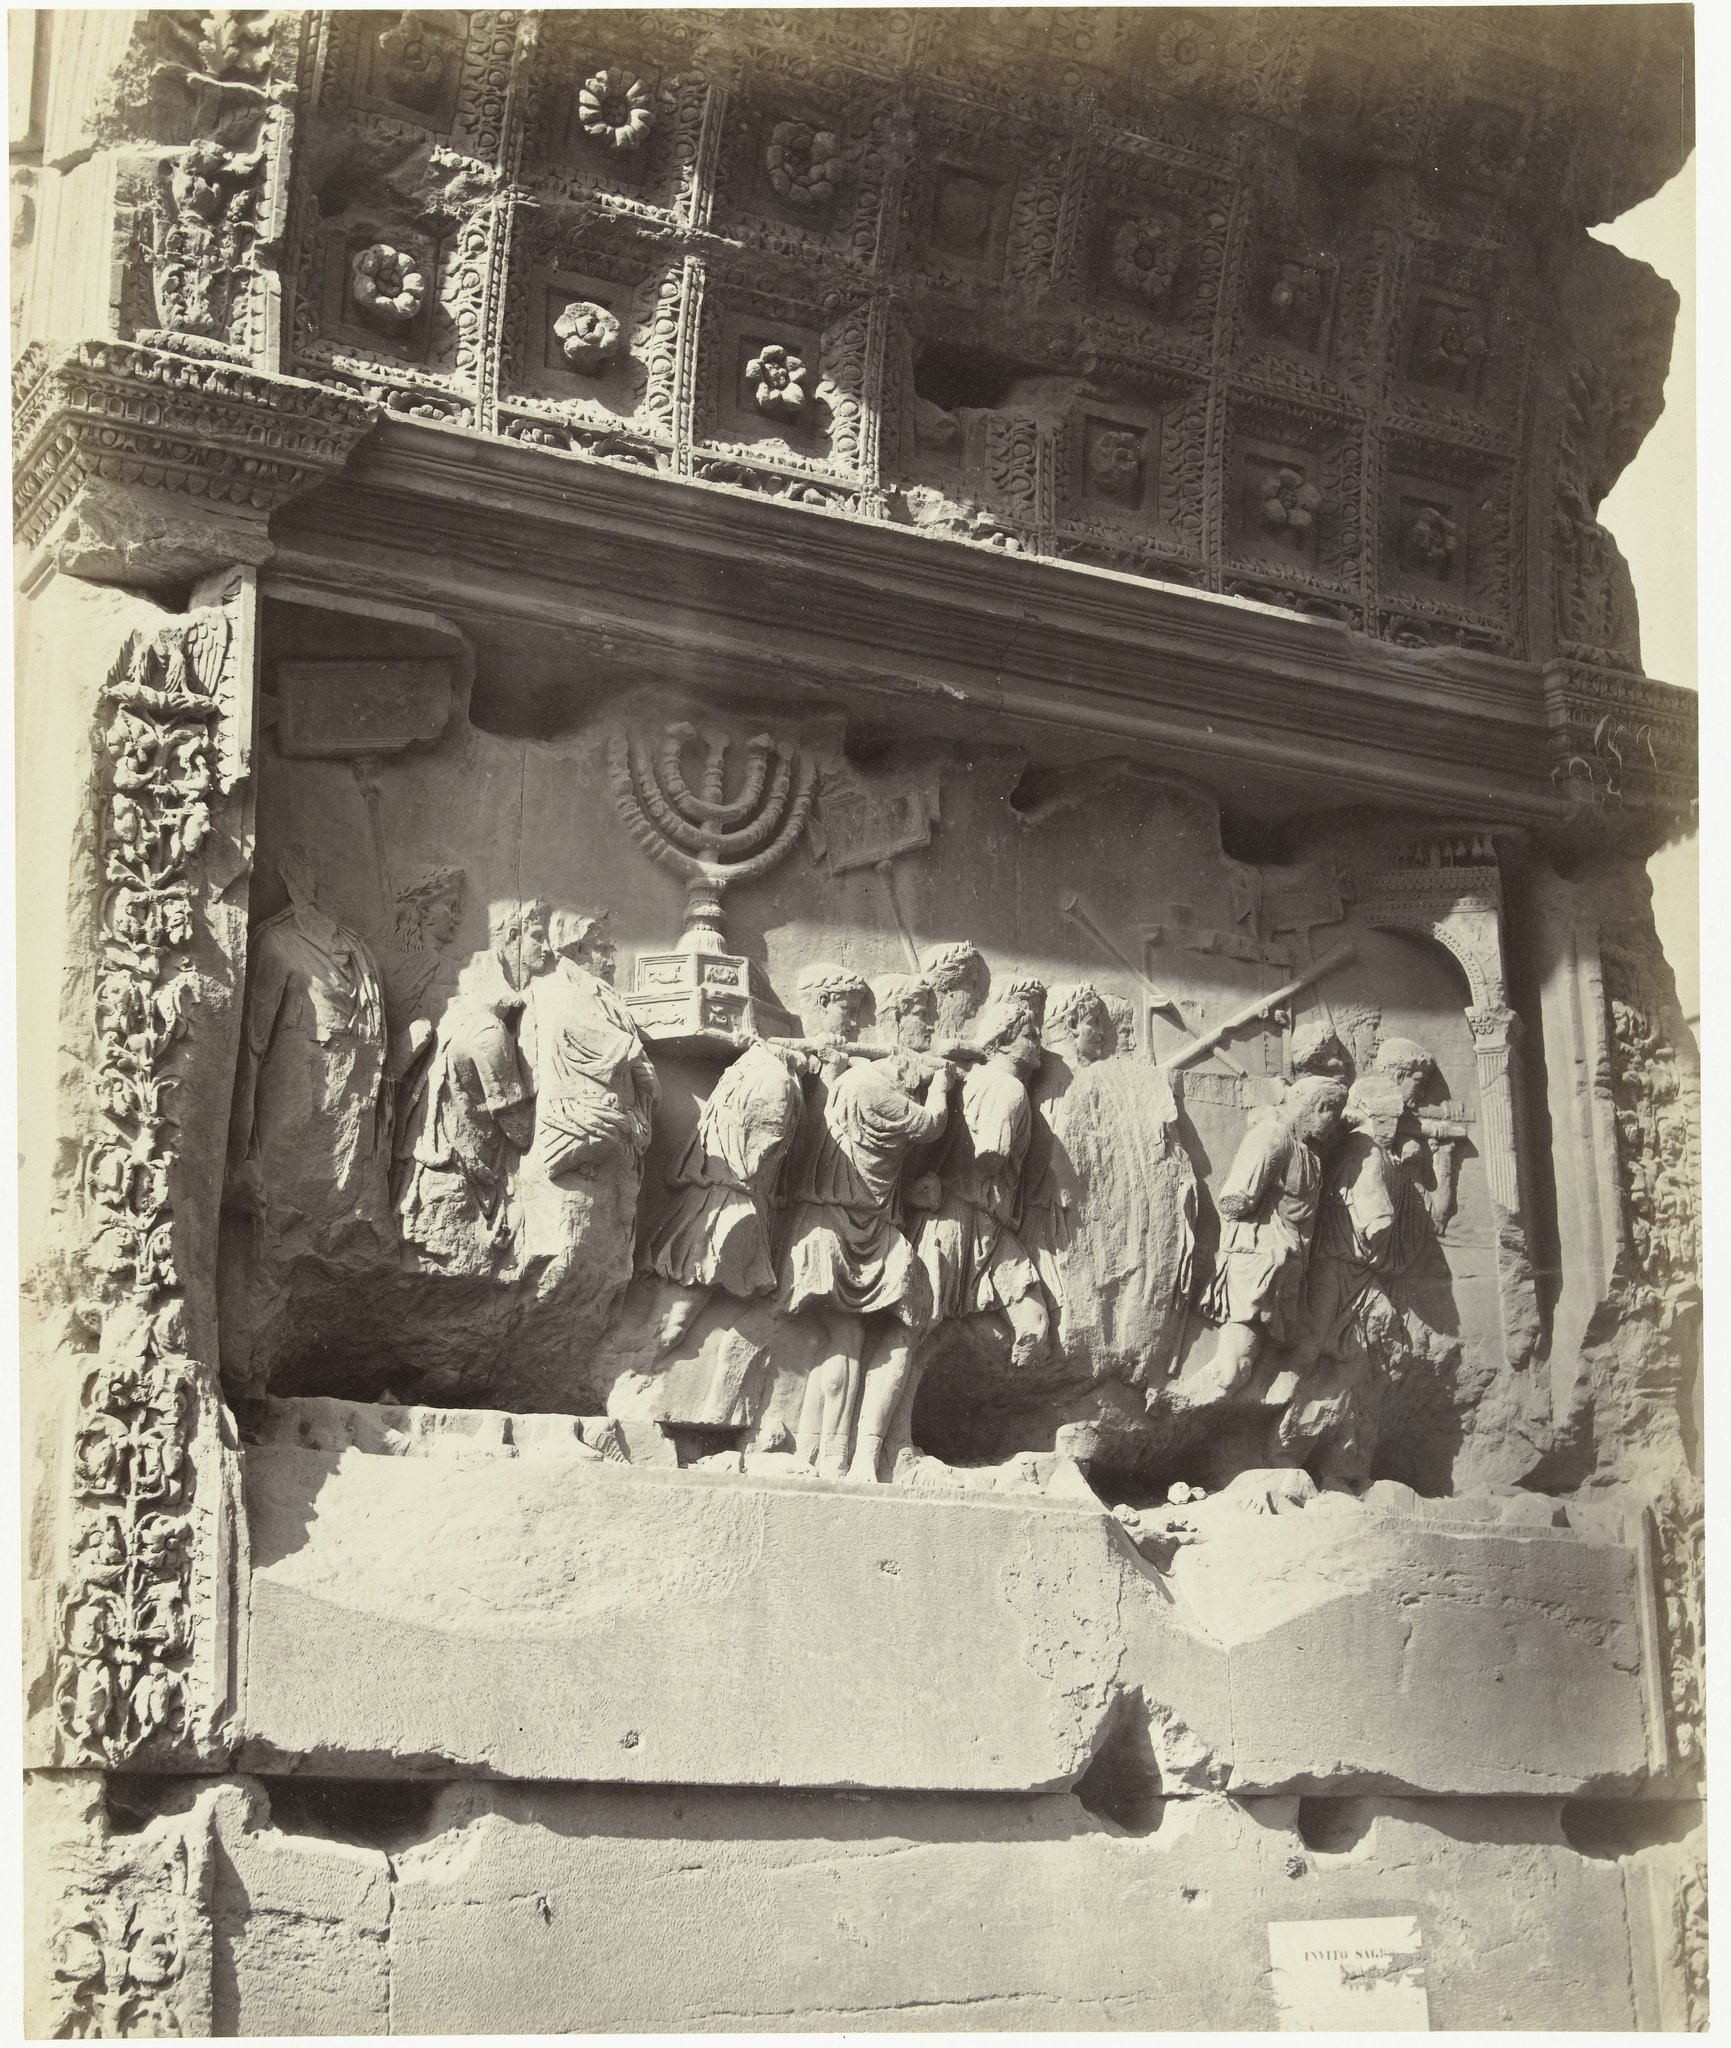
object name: photograph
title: Bas relief sans titre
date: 1858-1863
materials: paper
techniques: albumen print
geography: rome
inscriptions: annotation: ‘Rome 212. Bas relief sans titre [?]’, signature: ‘Bisson ainé’